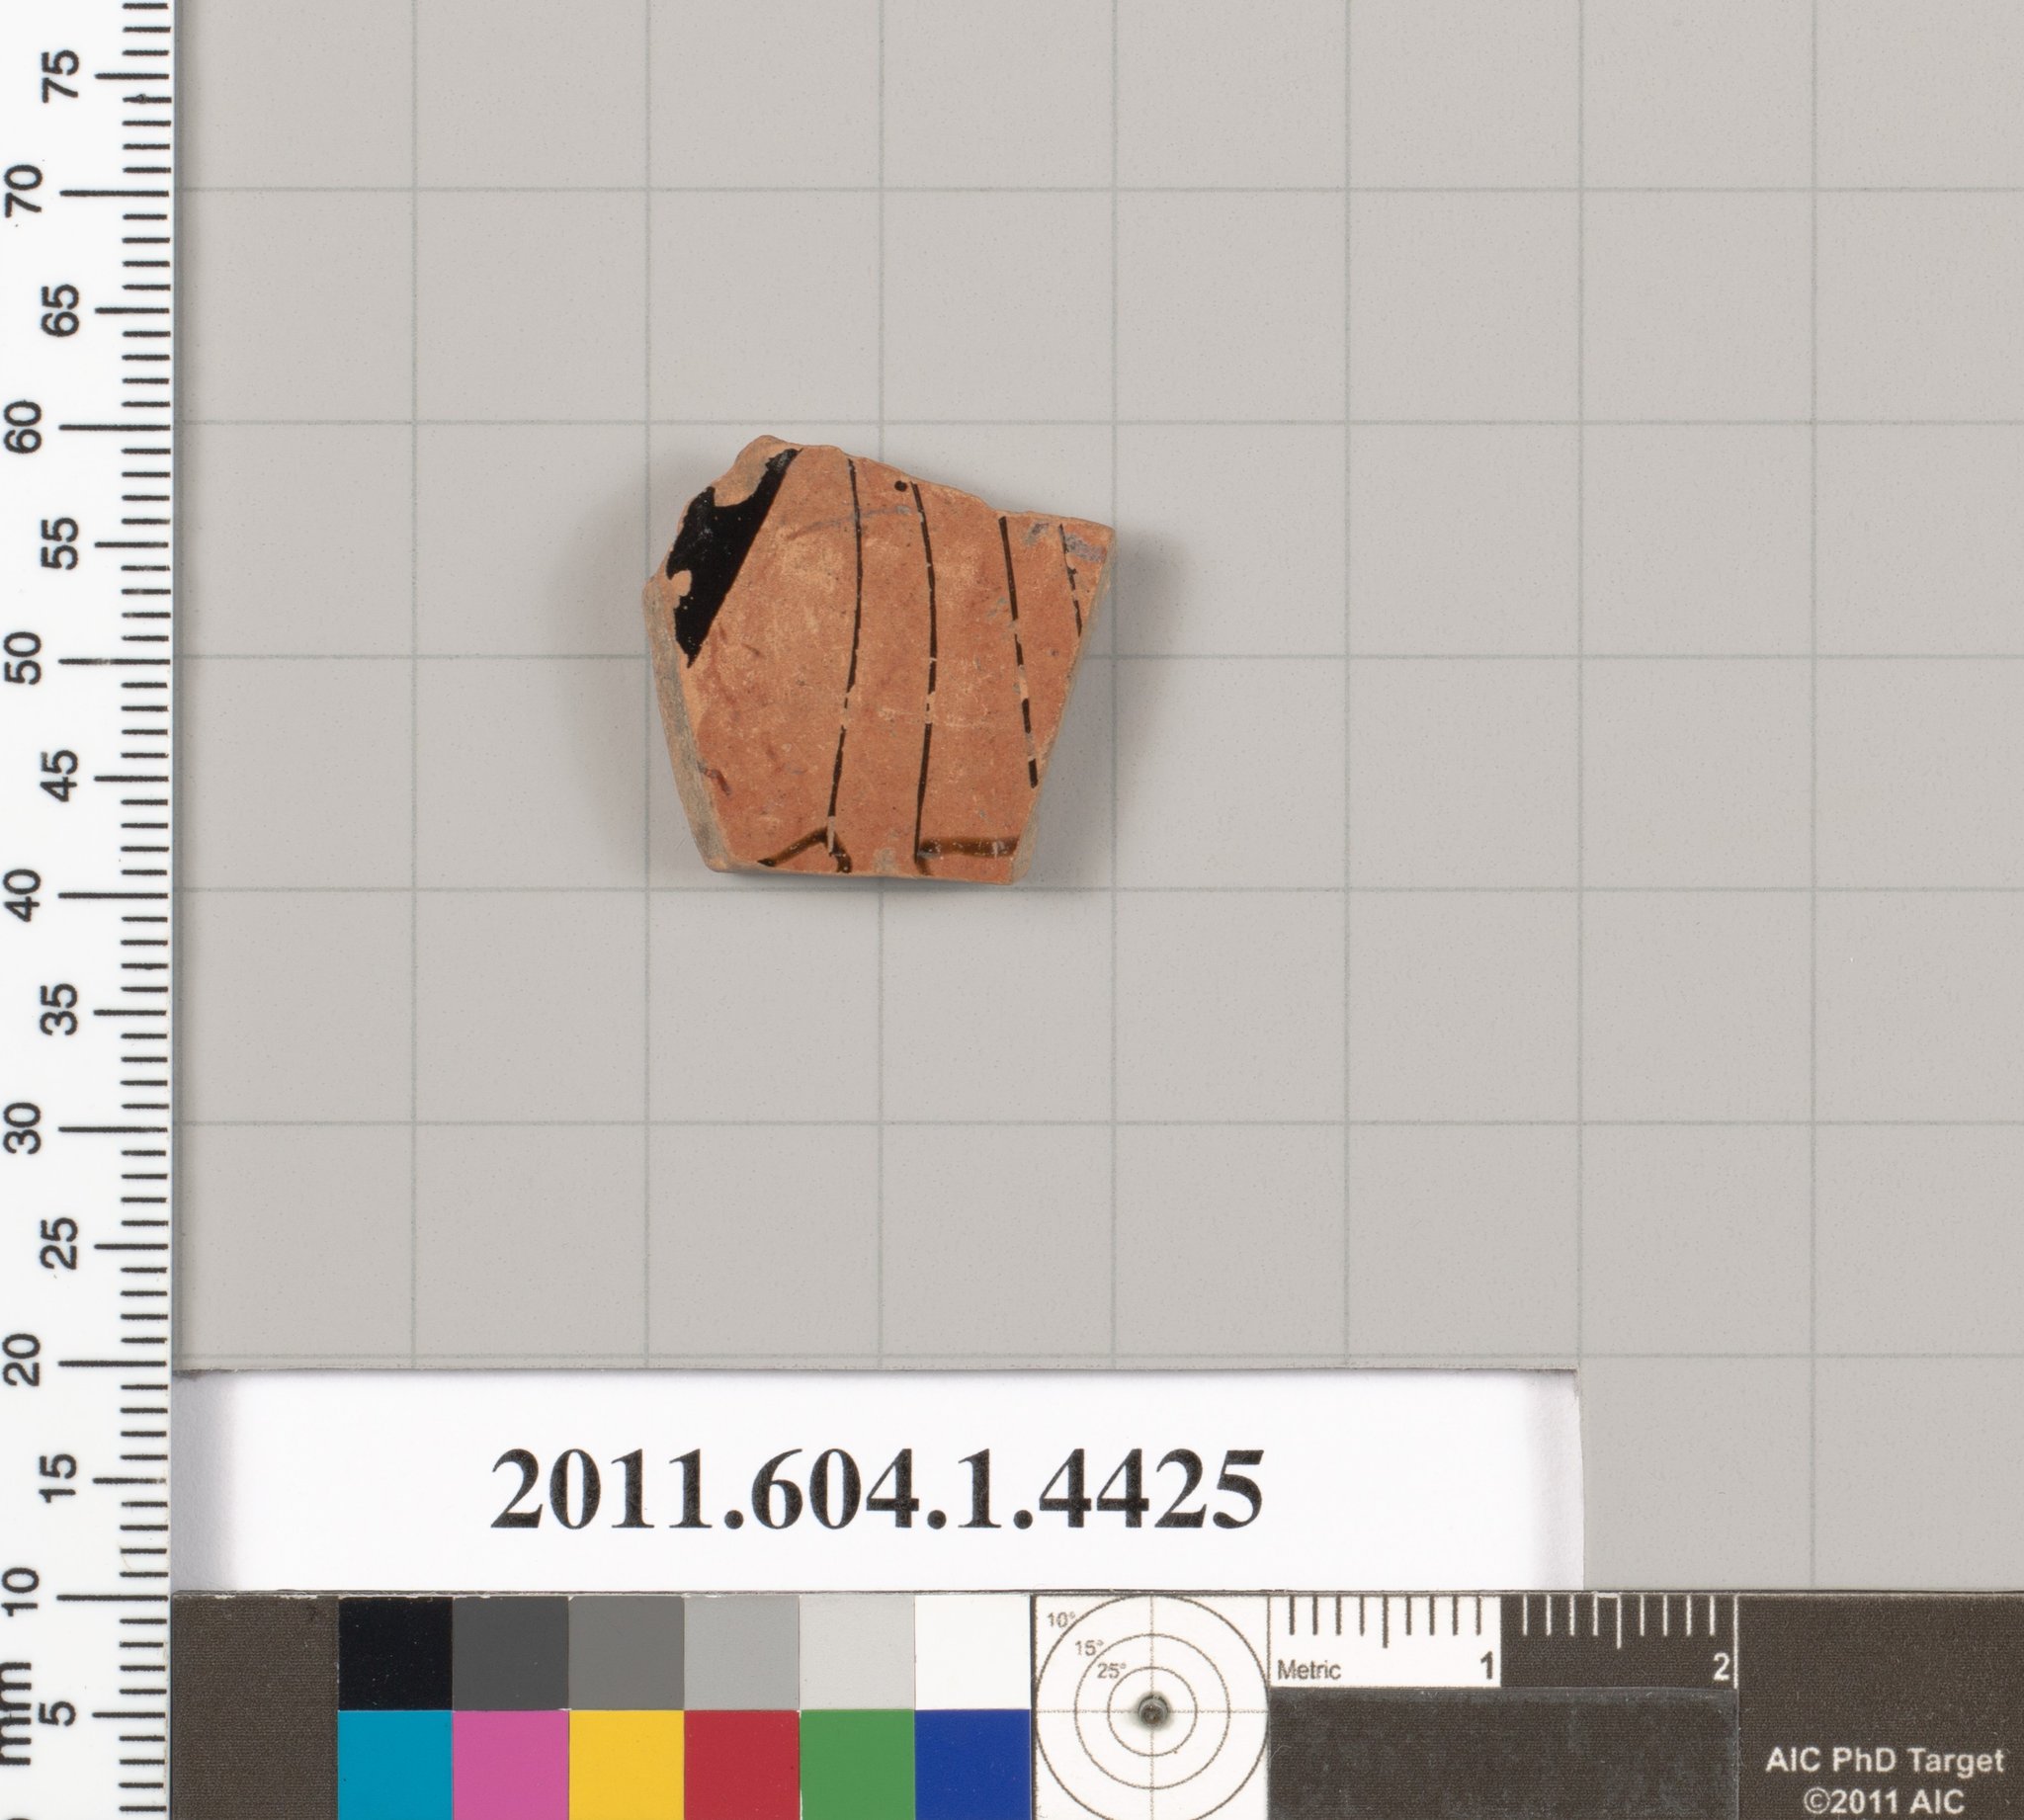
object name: kylix fragment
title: Terracotta fragment of a kylix (drinking cup)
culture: greek, attic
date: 475-451 BCE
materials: terracotta